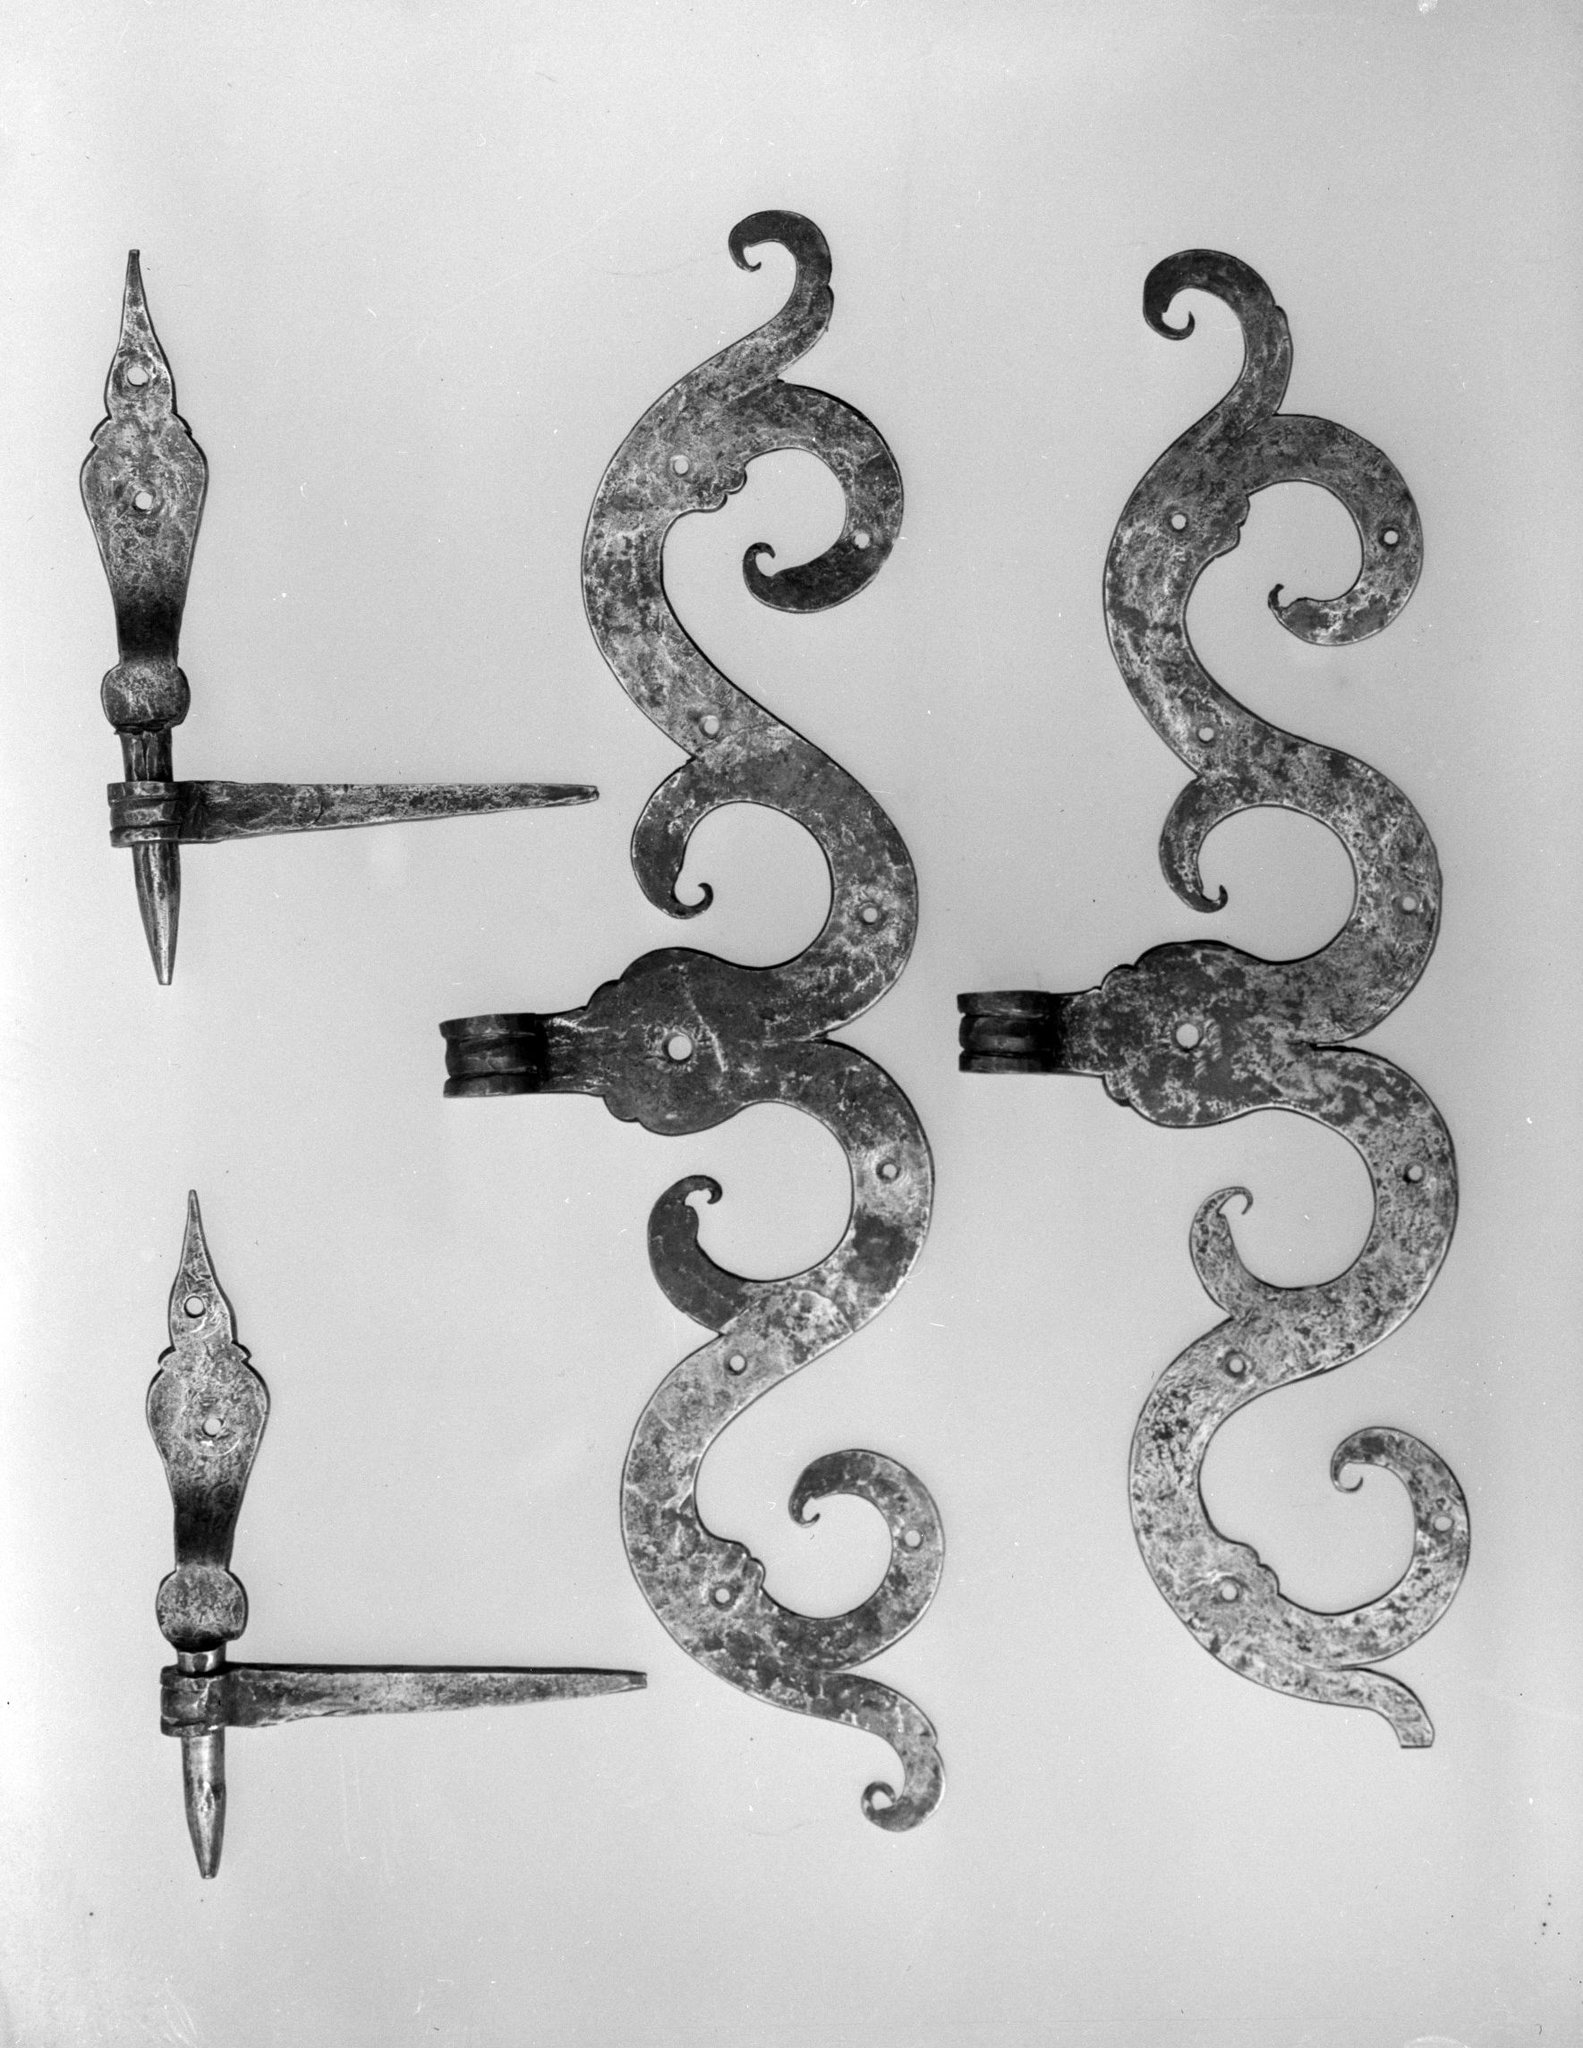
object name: hinge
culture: american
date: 1700-1800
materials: iron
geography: united states